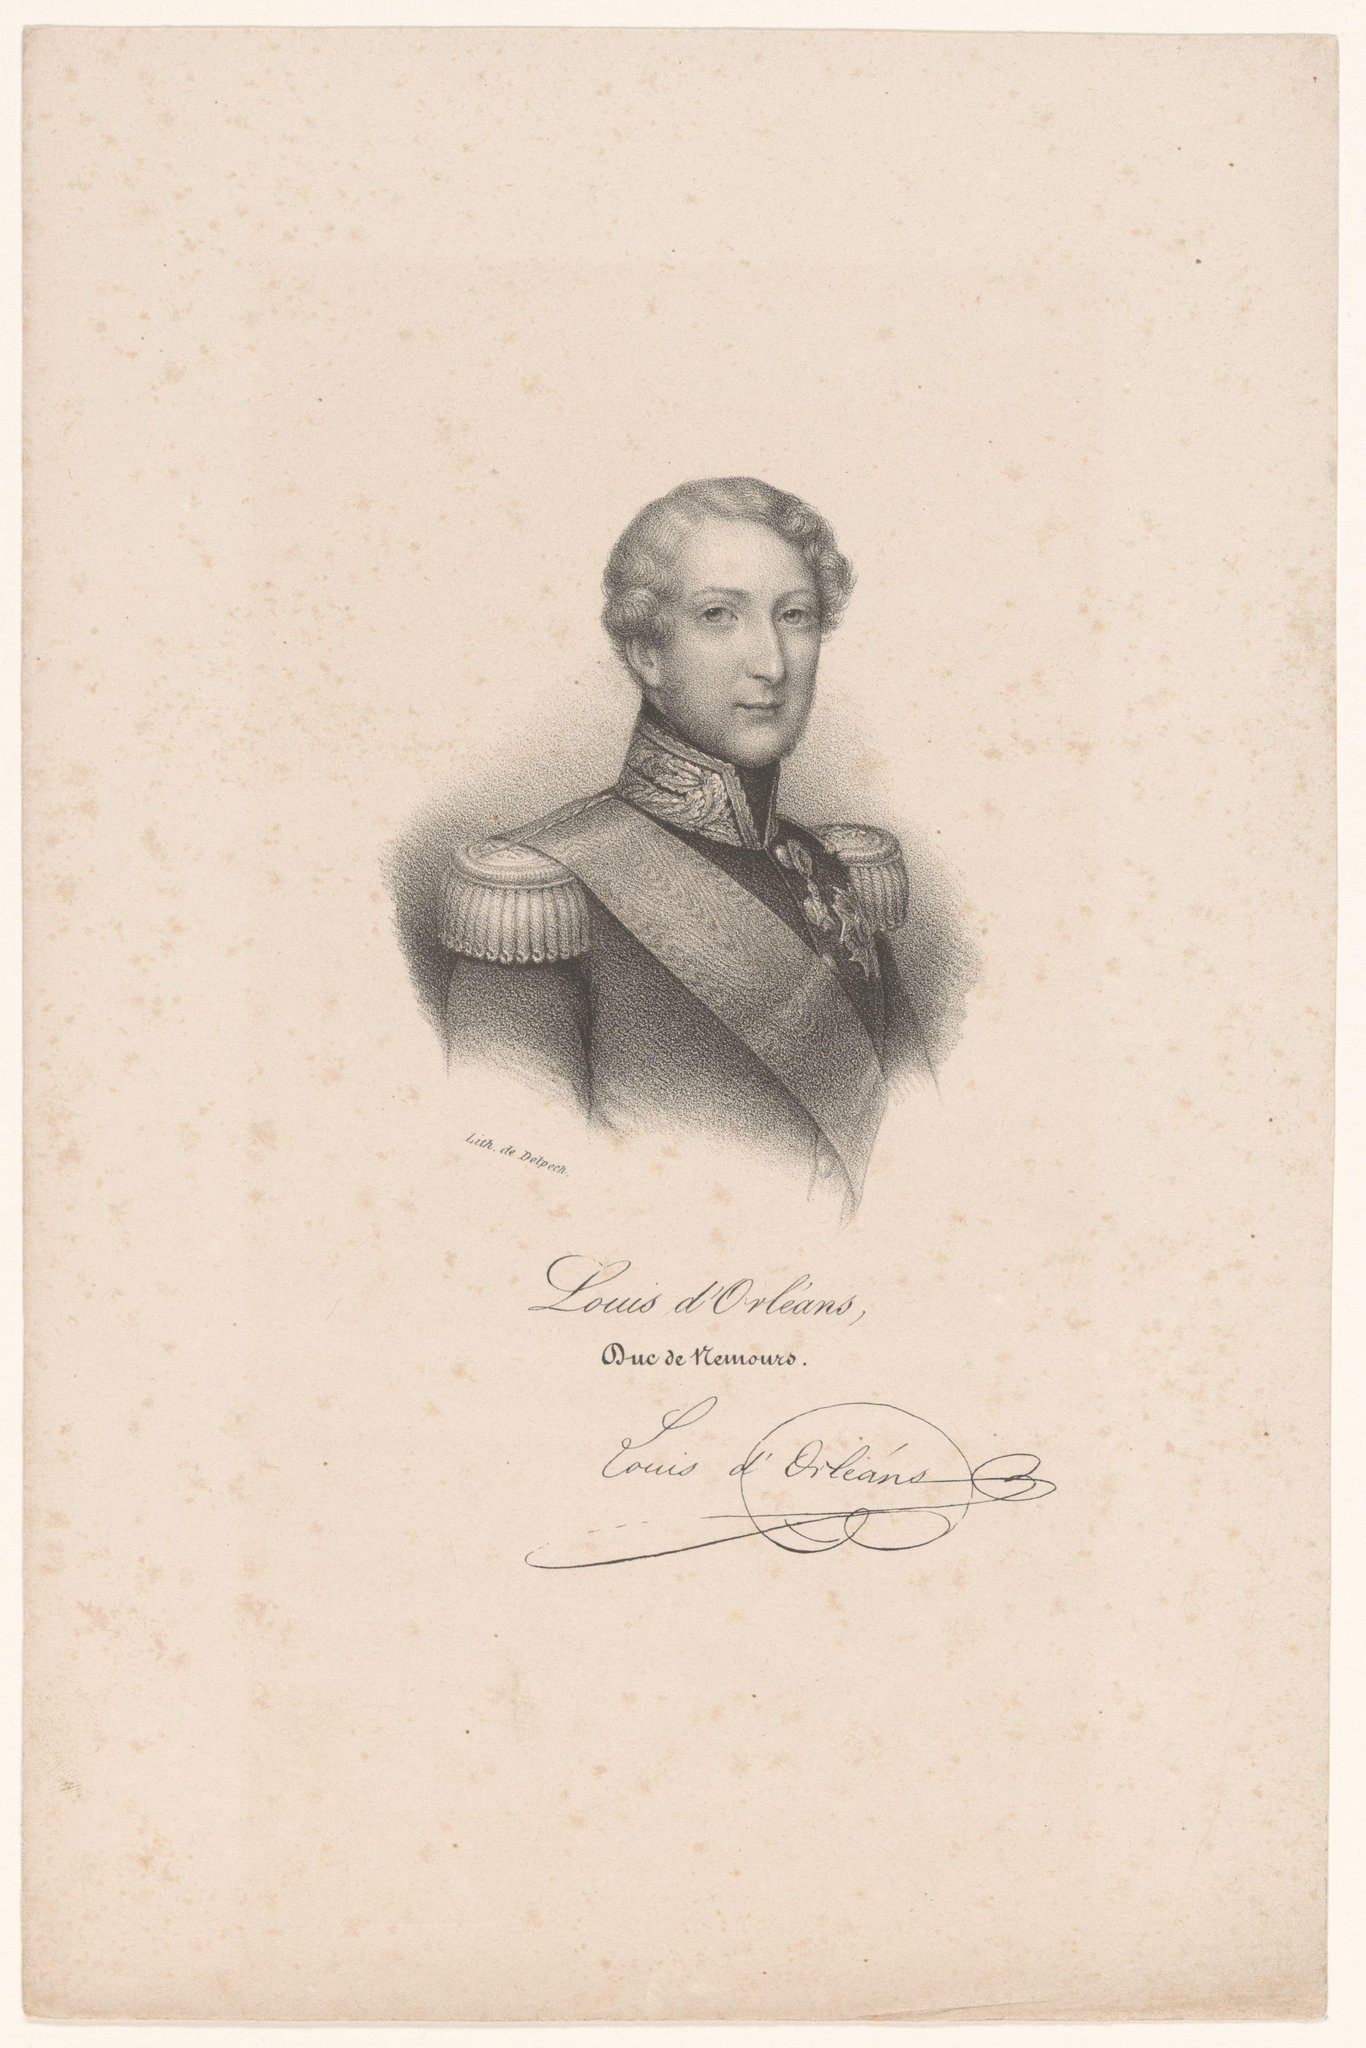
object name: print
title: Louis d'Orléans, duc de Nemours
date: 1839-1842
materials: paper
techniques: lithograph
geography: paris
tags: paris, historical persons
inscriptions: collector's mark: Lugt 2228a